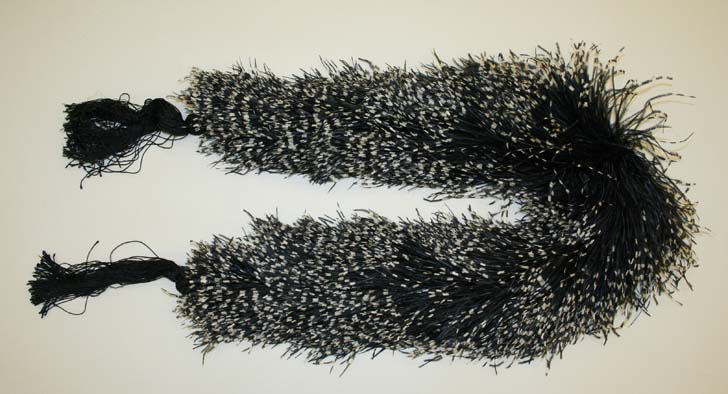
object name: boa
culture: american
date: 1890-1900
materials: feather, silk